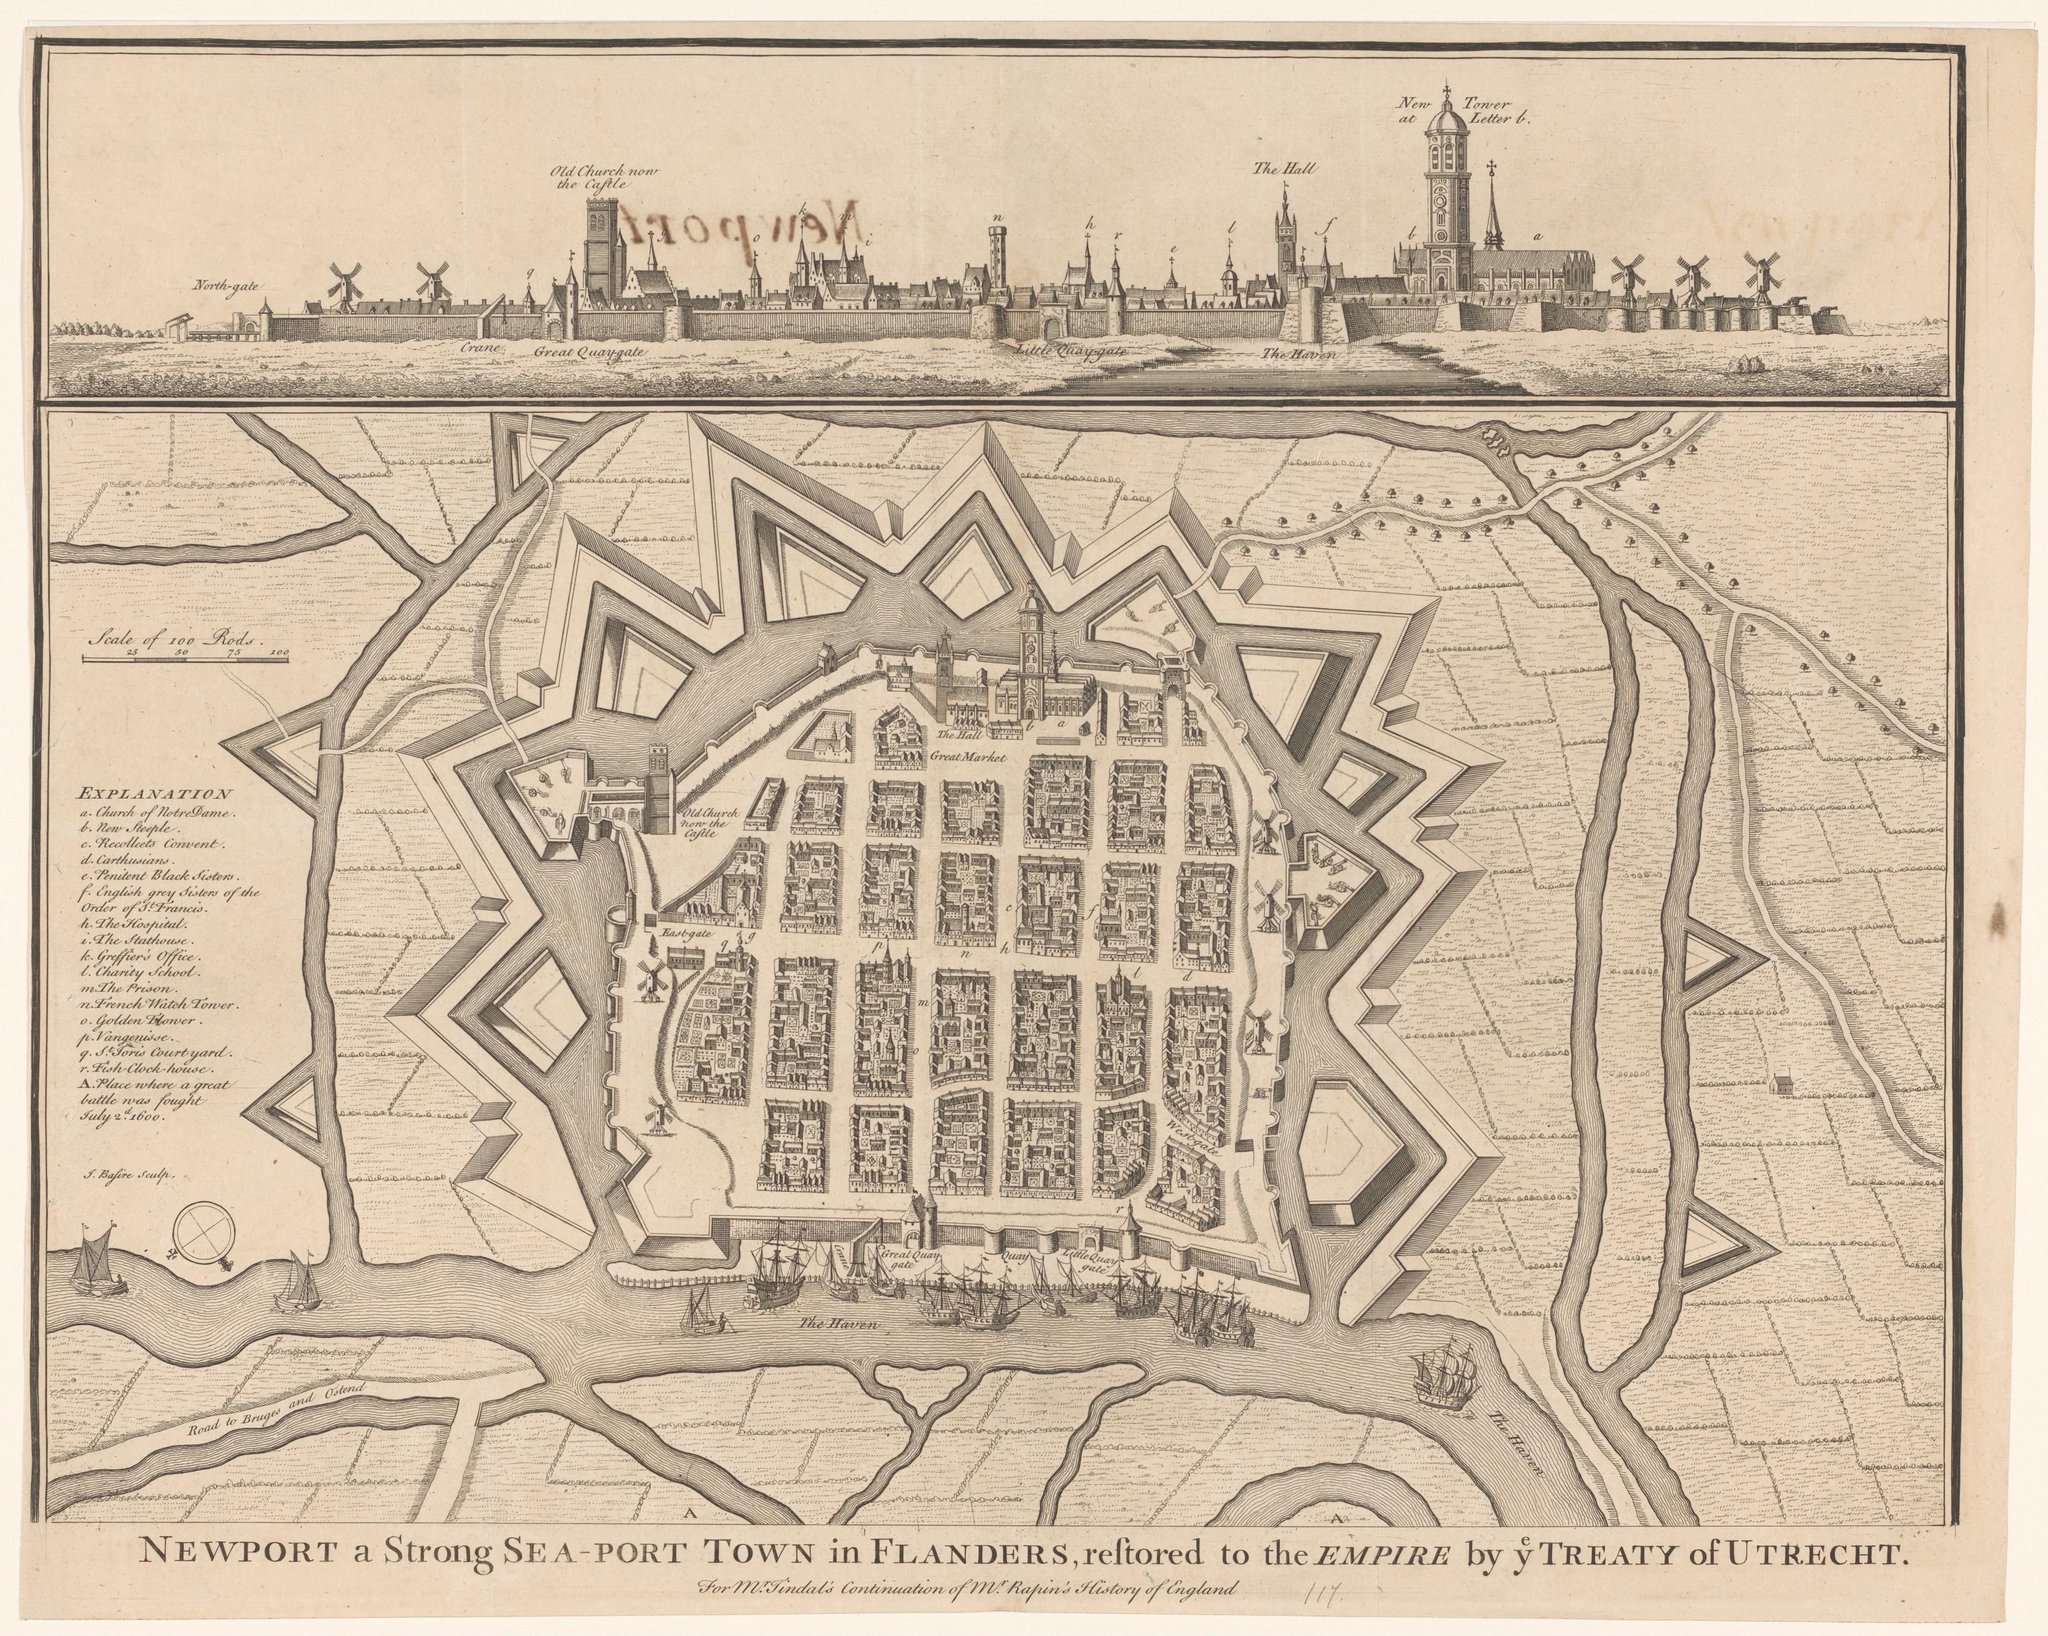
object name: print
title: Plattegrond van Nieuwpoort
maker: isaac basire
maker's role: print maker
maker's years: 1704-1768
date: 1751-1762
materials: paper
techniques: engraving, etching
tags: maps of cities, prospect of city, town panorama, silhouette of city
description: Plattegrond van Nieuwpoort met gebouwen in vogelvluchtperspectief. De titel in een balk onder de kaart. Boven de plattegrond een gezicht op Nieuwpoort. Langs de linkerrand van de plattegrond een legenda a-r en A, met daarboven een schaalstok: Schale of 100 Rods.